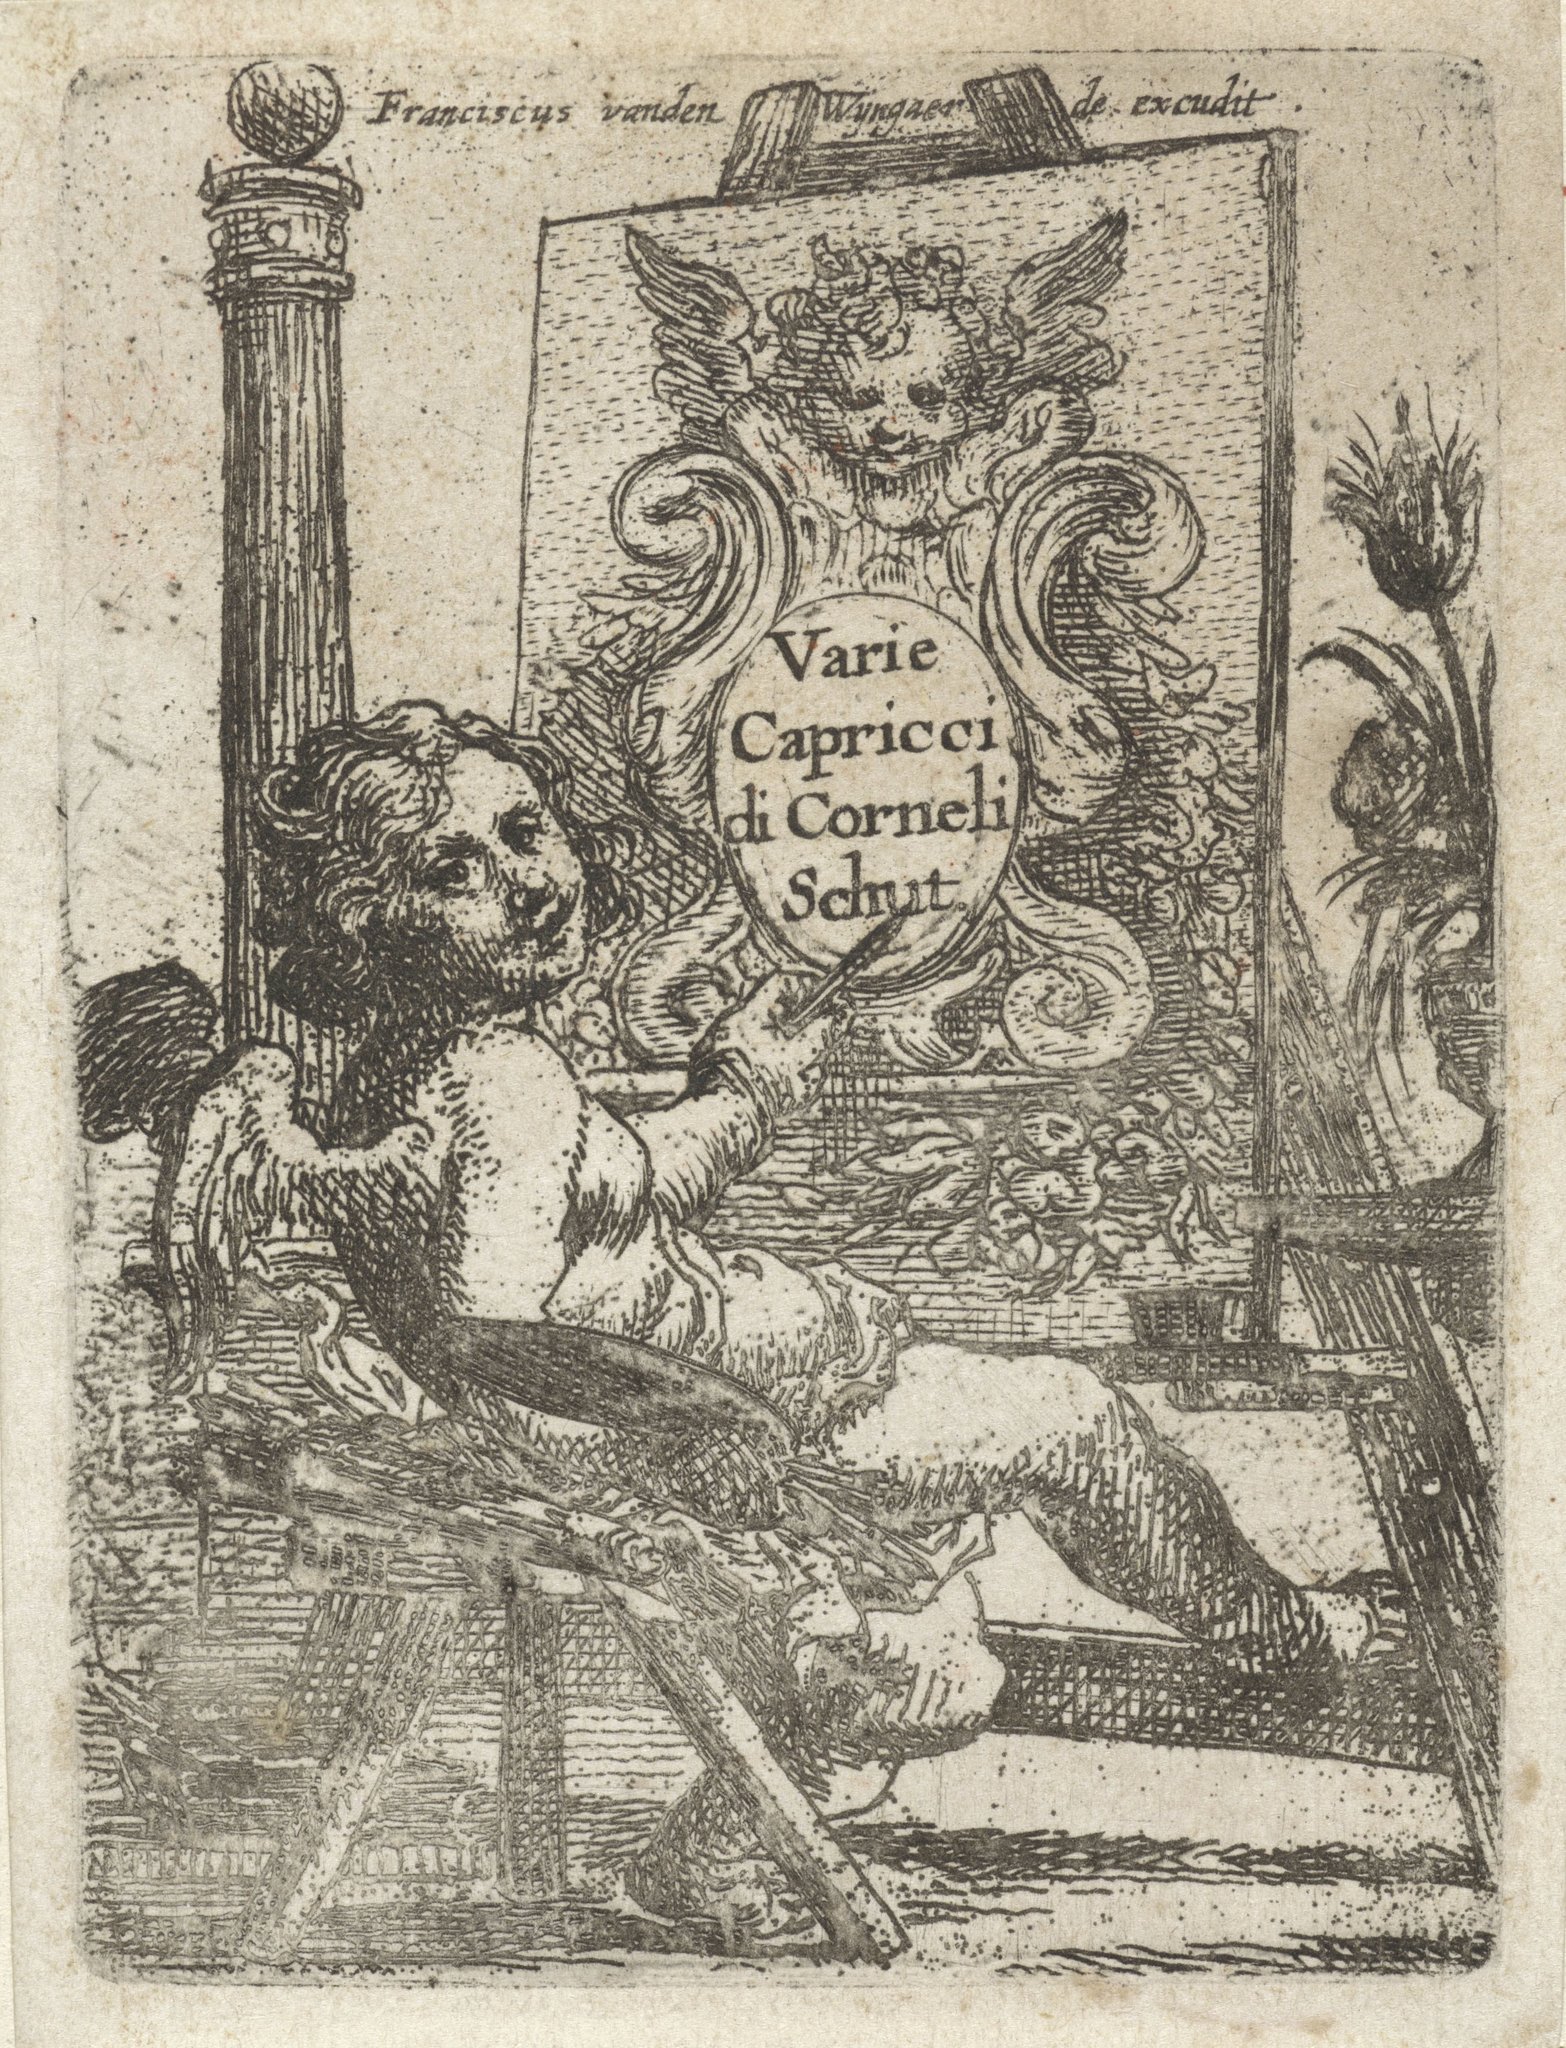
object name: titelprent, frontispice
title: Varie capricci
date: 1636-1679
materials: paper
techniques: engraving, etching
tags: easel, cupids: 'amores', 'amoretti', 'putti', working situations ~ painter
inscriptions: collector's mark: Lugt 240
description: Een putto zit op een schilderskrukje en werkt aan een schilderij op een ezel. Op het schilderij staat de titel van de serie plus een putto-kopje.